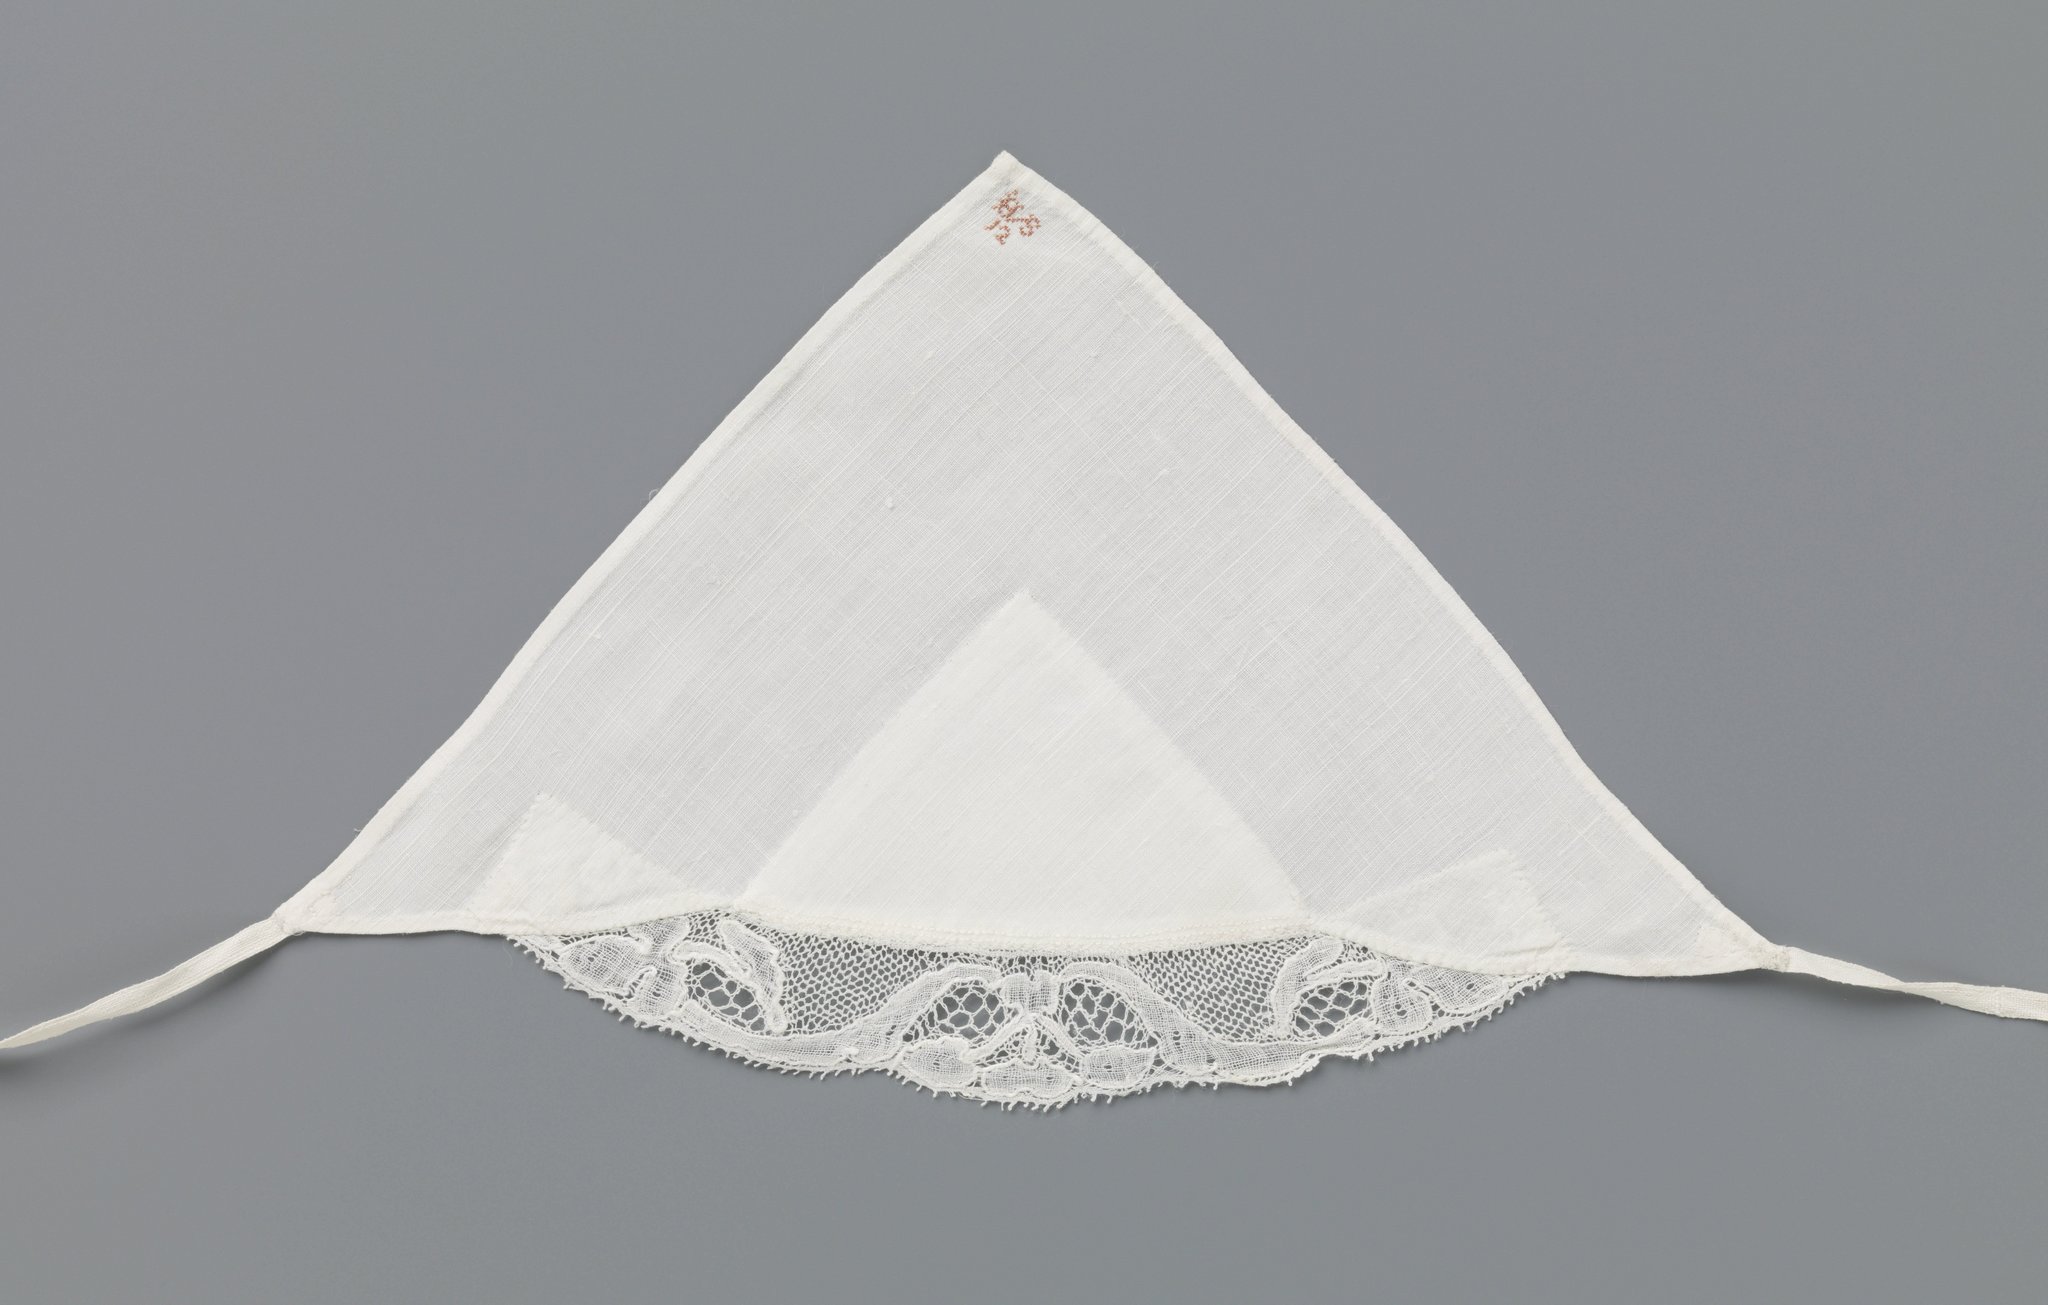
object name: fontaneldoek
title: Fontaneldoek met een randje kloskant van Helena van Slingelant-Slicher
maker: Anonymous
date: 1759-1764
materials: linen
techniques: lace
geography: southern netherlands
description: Fontaneldoek van naturelkleurig linnen met aan één zijde een randje naturelkleurige kloskant: Mechelse kant. Het 'hersenpanlapje voor borelingen' heeft een driehoekig model. Het randje kant is licht gebogen, glad aangezet en beslaat een groot deel van de langste zijde van de driehoek. De gebogen uiteinden overlappen deels het linnen. Het kantpatroon is symmetrisch en bestaat uit een rank in accolade-vorm met drie eenvoudige bloem- of bladvormen. De motieven zijn met elkaar verbonden door een traliegrond. De motieven zijn gemaakt in linnenslag en er is één soort siergrond gebruikt. De motieven zijn voorzien van dikkere glimmende contourdraden. Op de twee hoeken van het doekje, links en rechts van de zijde waaraan het kant is bevestigd, is een lang smal linnen bandje bevestigd. Op de derde hoek is het doekje gemerkt met rood borduursel met HVS/12, dat staat voor Helena van Slingelant-Slicher.